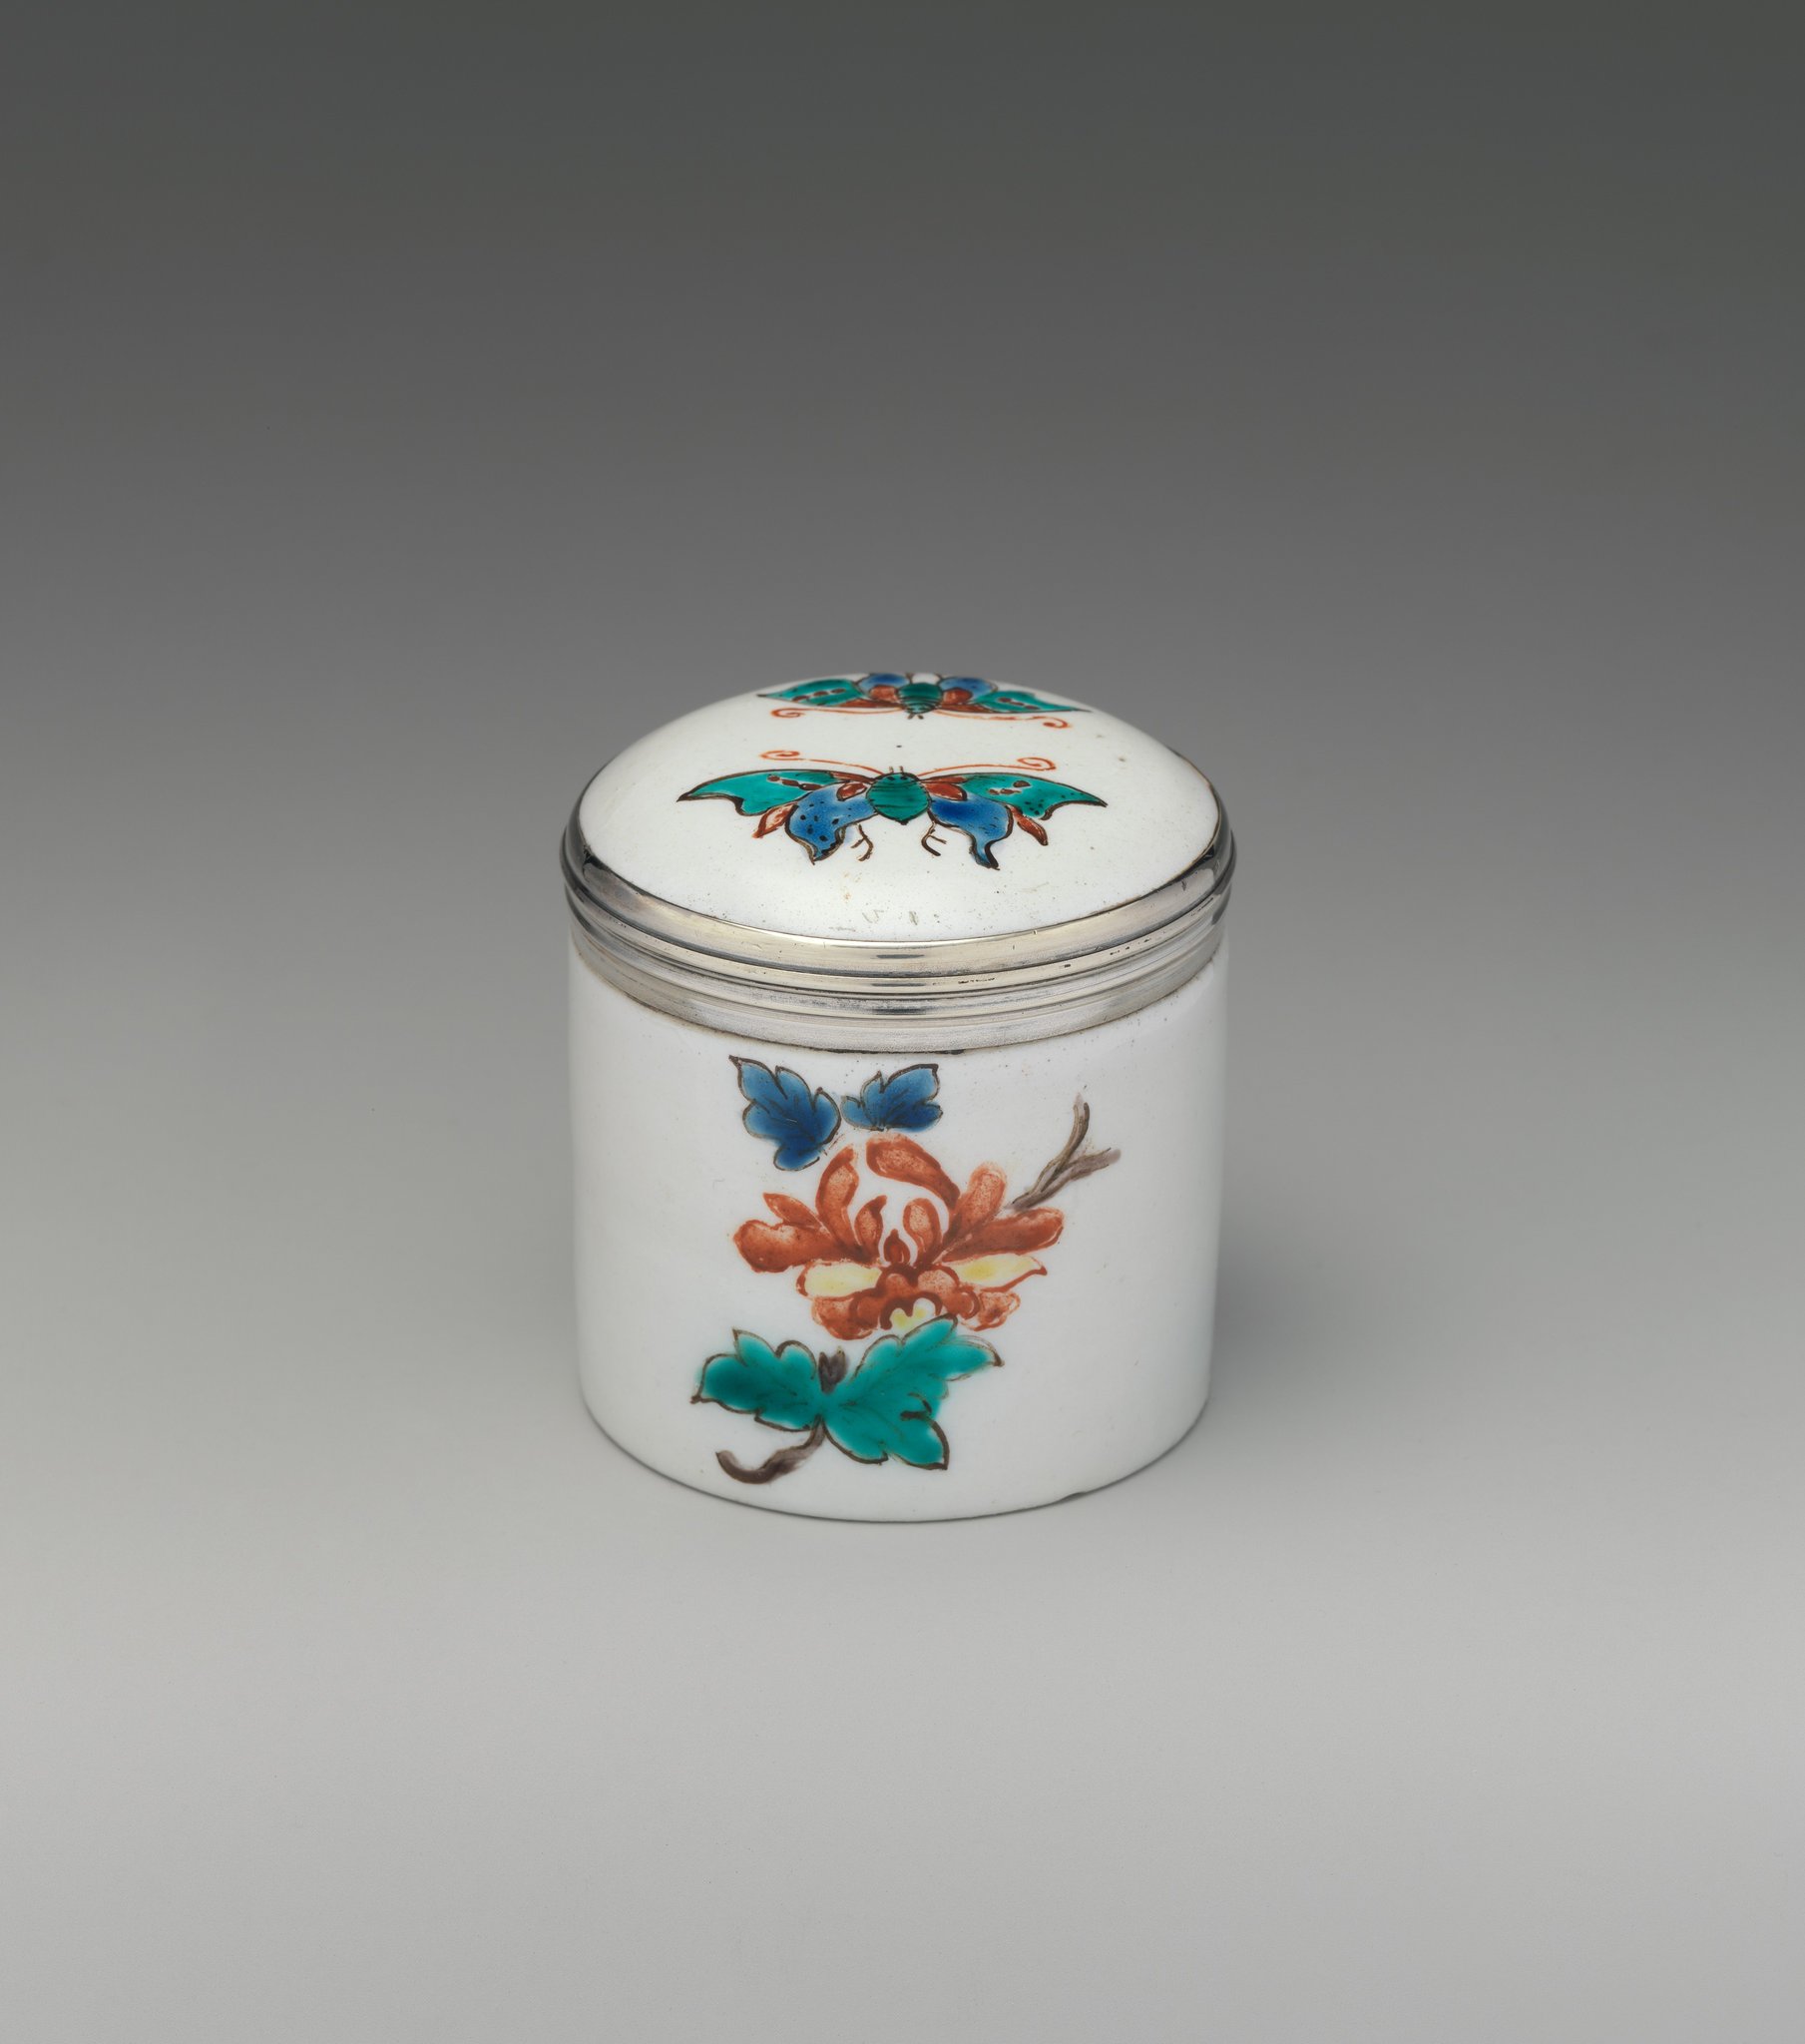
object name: pomade pot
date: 1735-1740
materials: silver, soft paste porcelain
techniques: glazing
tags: butterflies,flowers